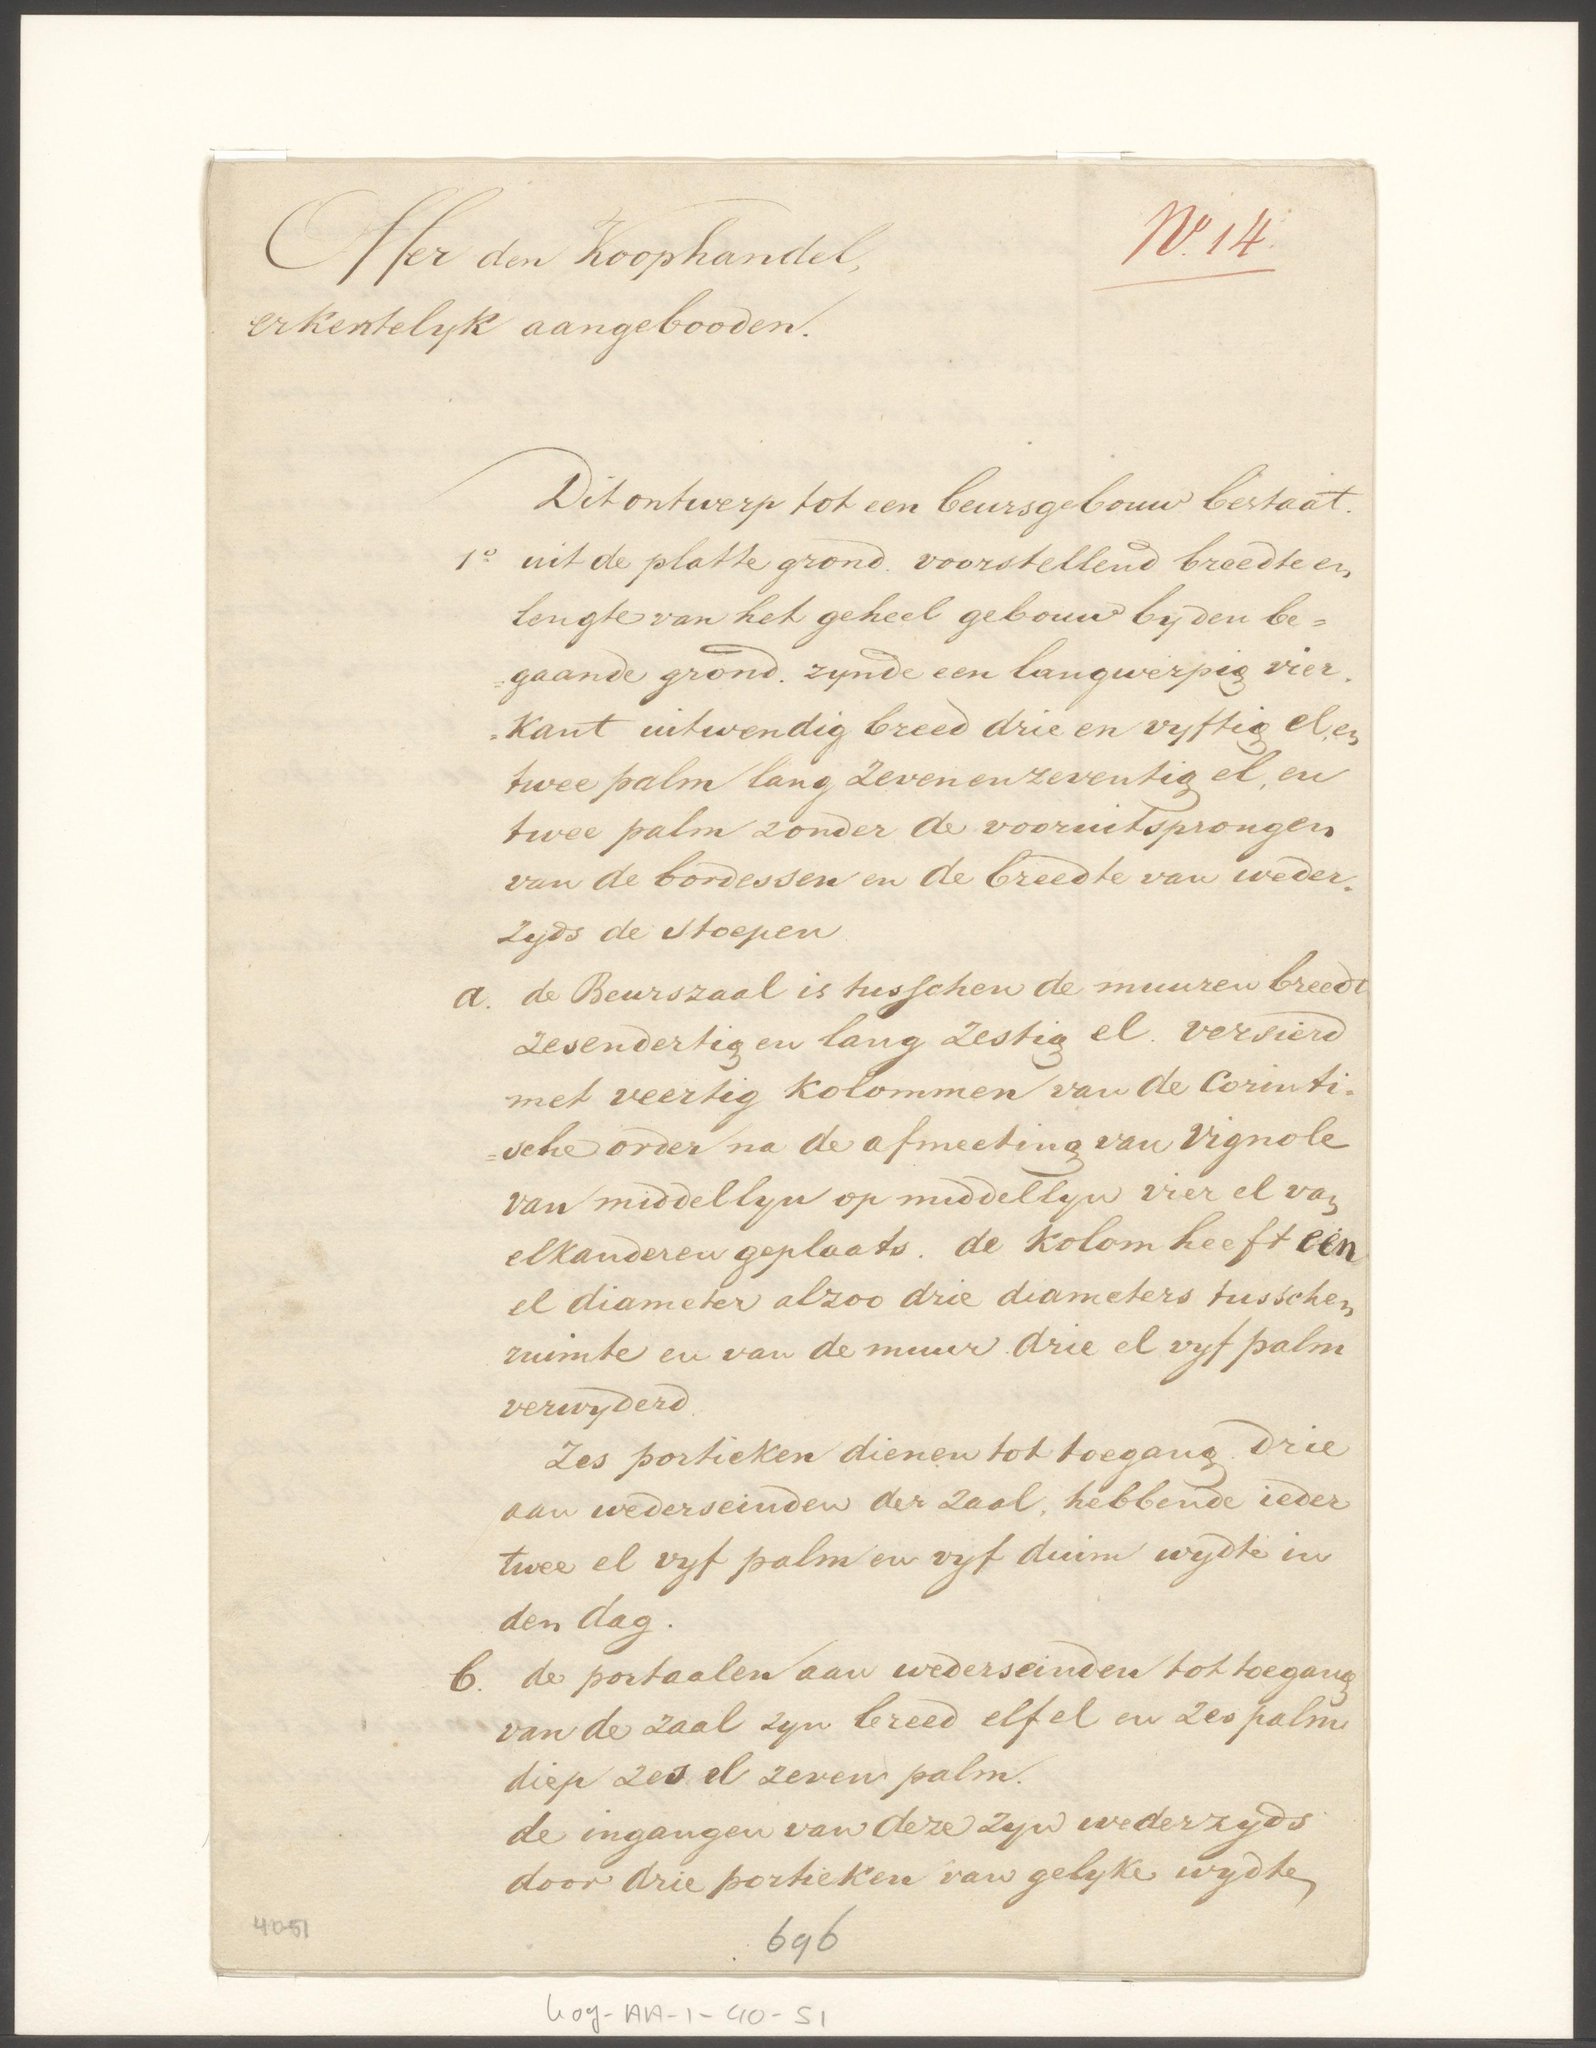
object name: manuscript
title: Offerte bij tekeningen voor een nieuw beursgebouw te Amsterdam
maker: Anonymous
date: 1836-1840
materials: paper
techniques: pen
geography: netherlands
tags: stock exchange, stock-market, amsterdam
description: Object bestaat uit drie aan elkaar gebonden bifolia. Onderwerpsrubriek binnen de Atlas Amsterdam: Handel en Zeevaart: Hulpbeurs op de Dam en Beurs (Dam).